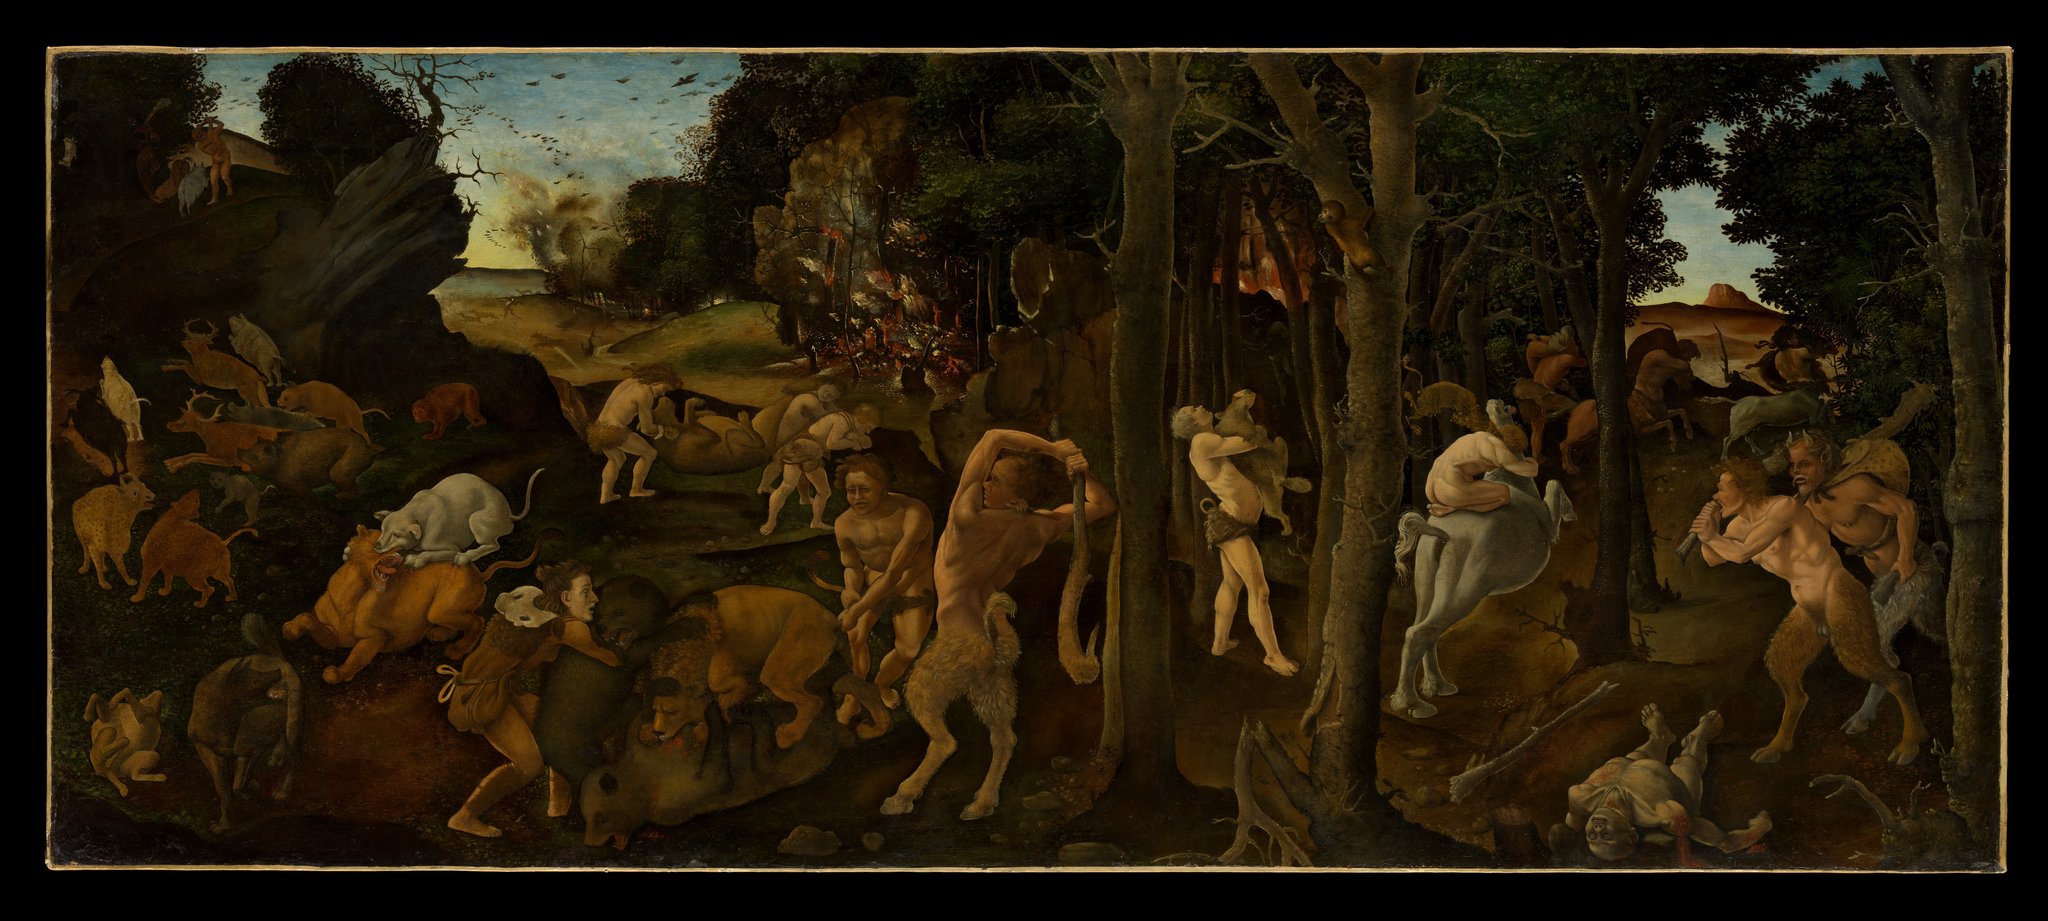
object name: painting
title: A Hunting Scene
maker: piero di cosimo (piero di lorenzo di piero d'antonio)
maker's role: artist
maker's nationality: italian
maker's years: 1462-1522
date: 1494-1500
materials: oil, paint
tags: bears,men,hunting,centaurs,satyrs,deer,dogs,lions,forests